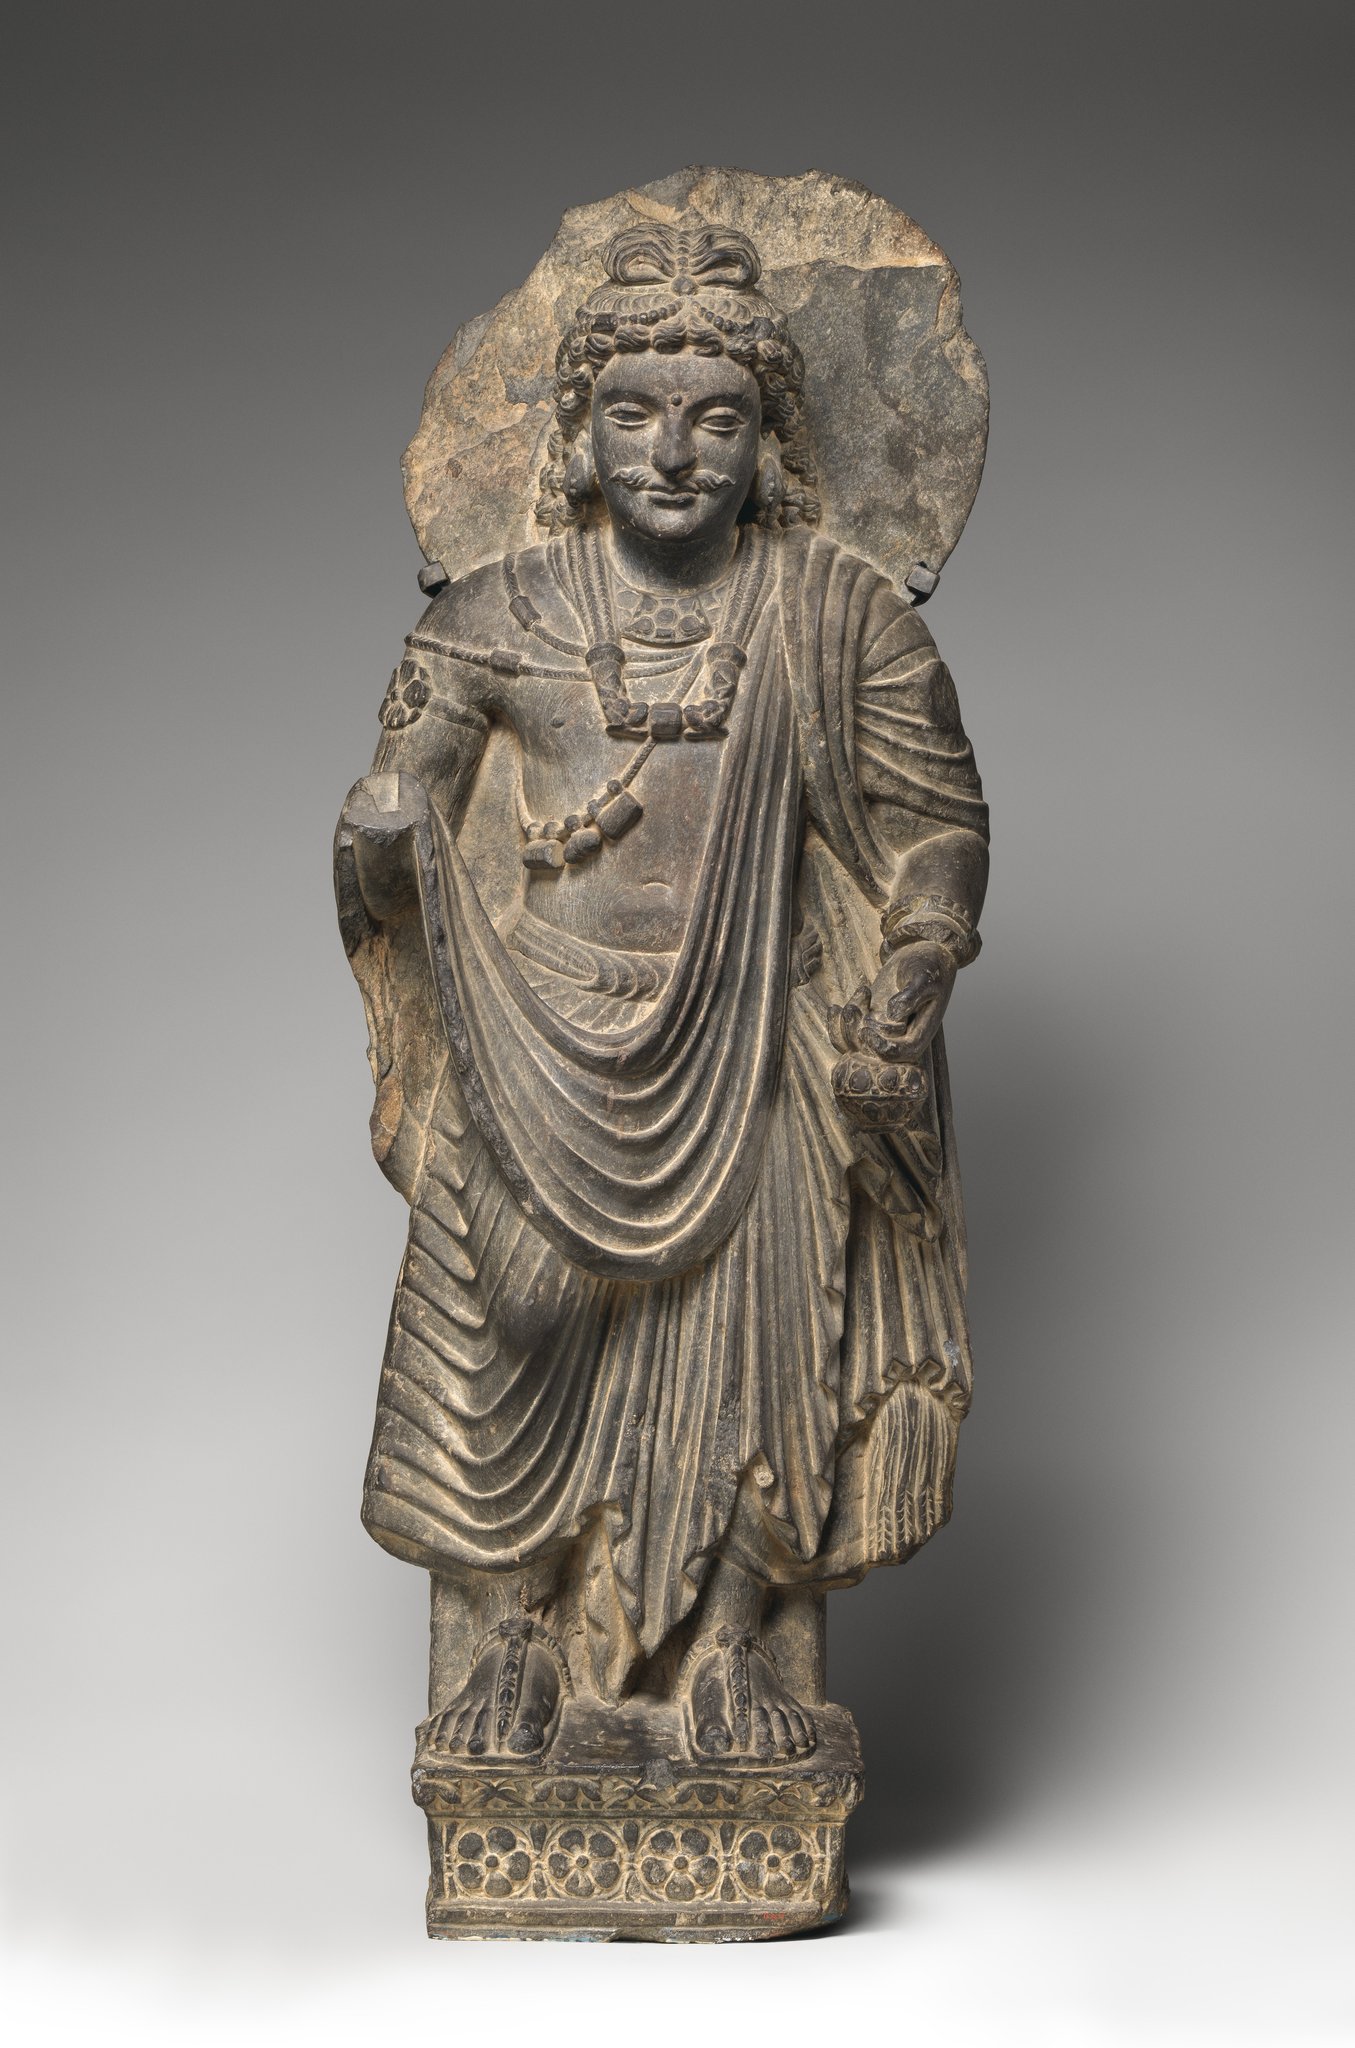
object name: figure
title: Standing Bodisattva Maitreya (Buddha of the Future)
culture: gandhara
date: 201-300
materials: stone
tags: gandhara,buddhism,bodhisattvas,maitreya